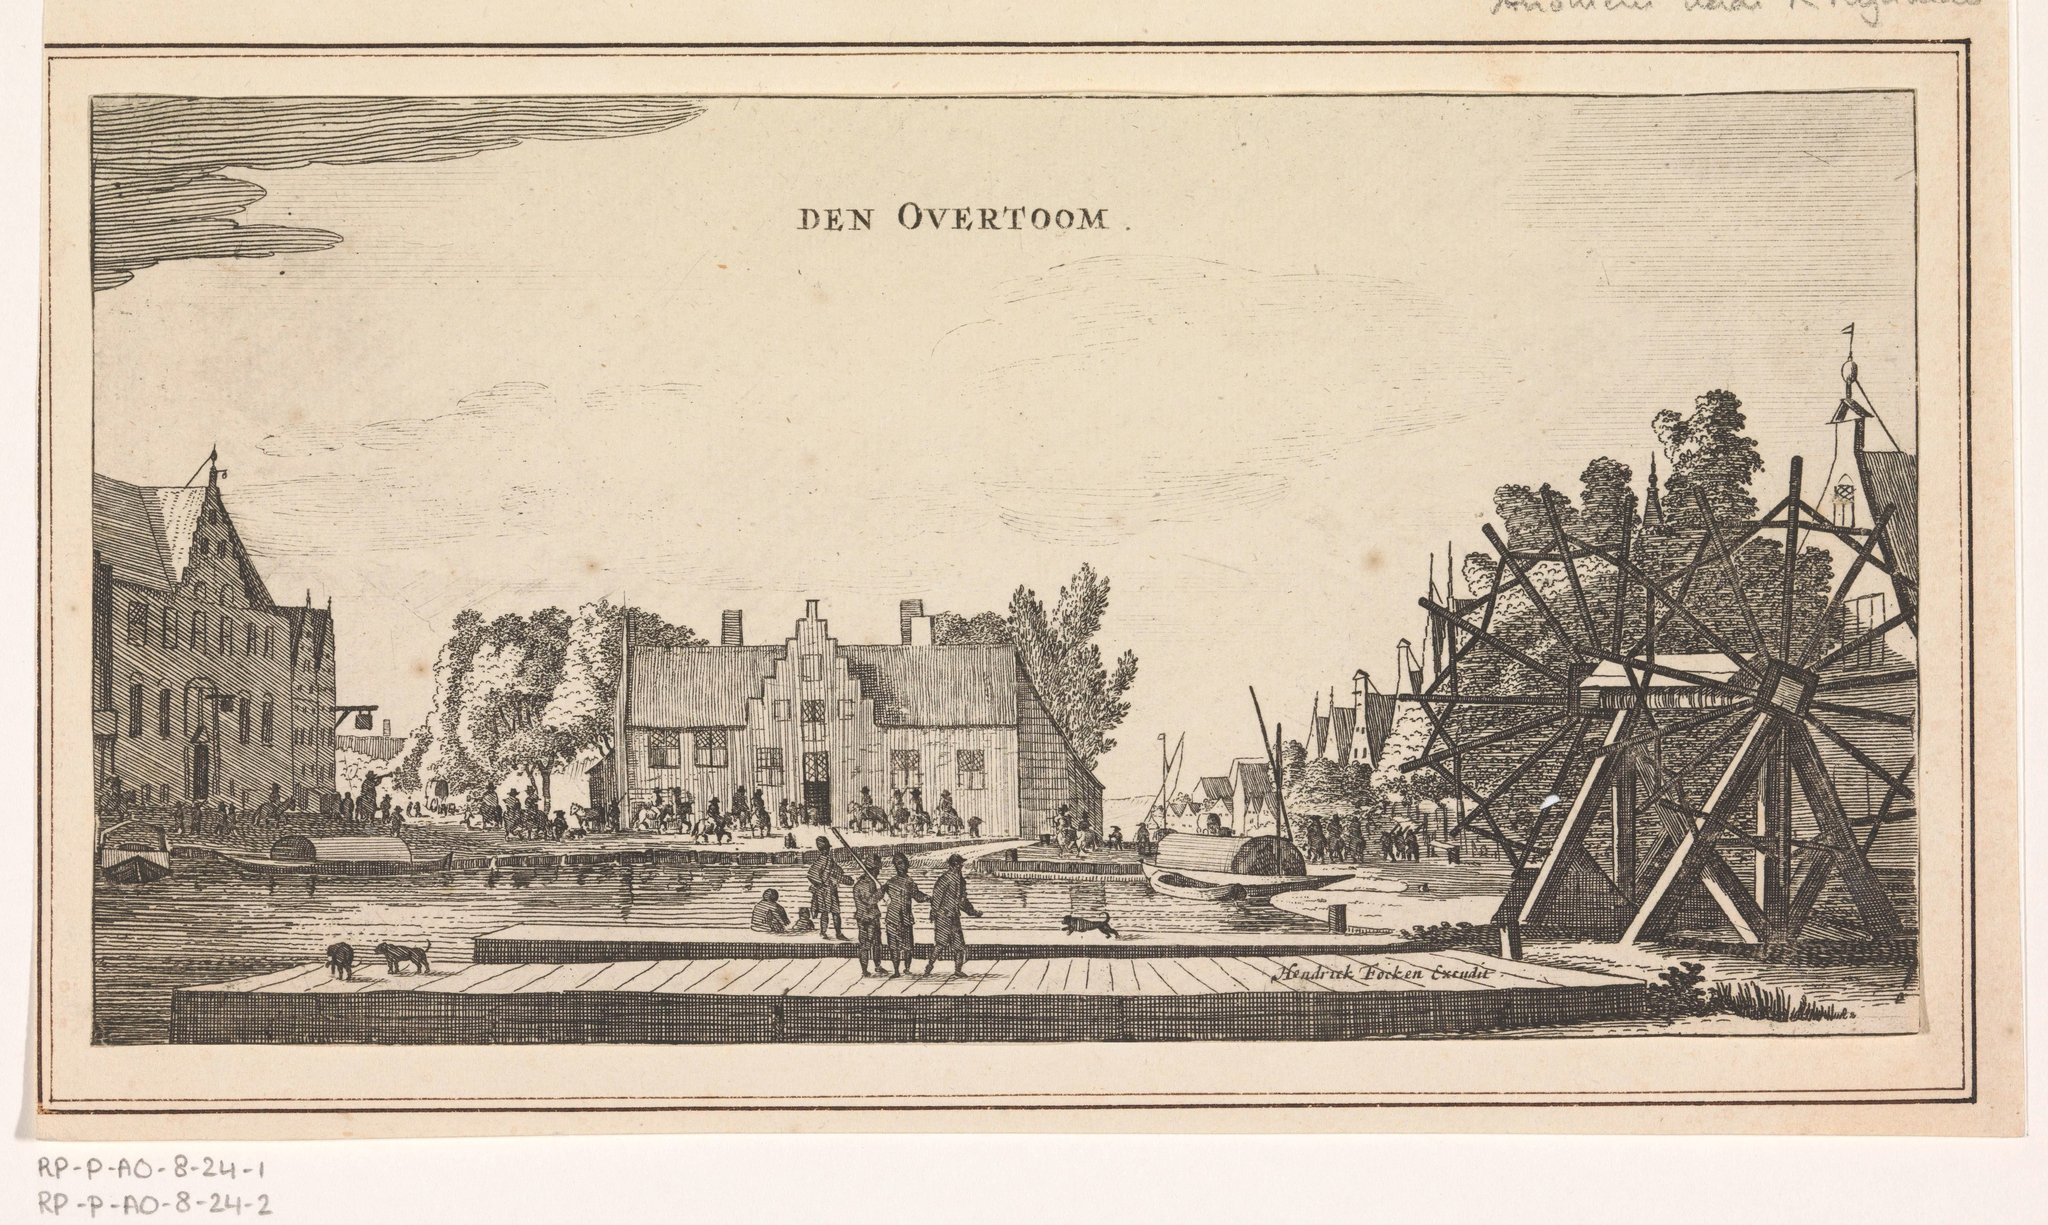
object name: print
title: Overtoom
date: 1665-1689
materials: paper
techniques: etching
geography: northern netherlands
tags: william ii (prince of orange)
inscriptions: collector's mark: Lugt 195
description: Gezicht op de Overtoom. Onderdeel van een serie van zes gezichten in de dorpen waar de troepen van prins Willem II ingekwartierd lagen tijdens het beleg van Amsterdam, van 30 juli tot 4 augustus 1650.